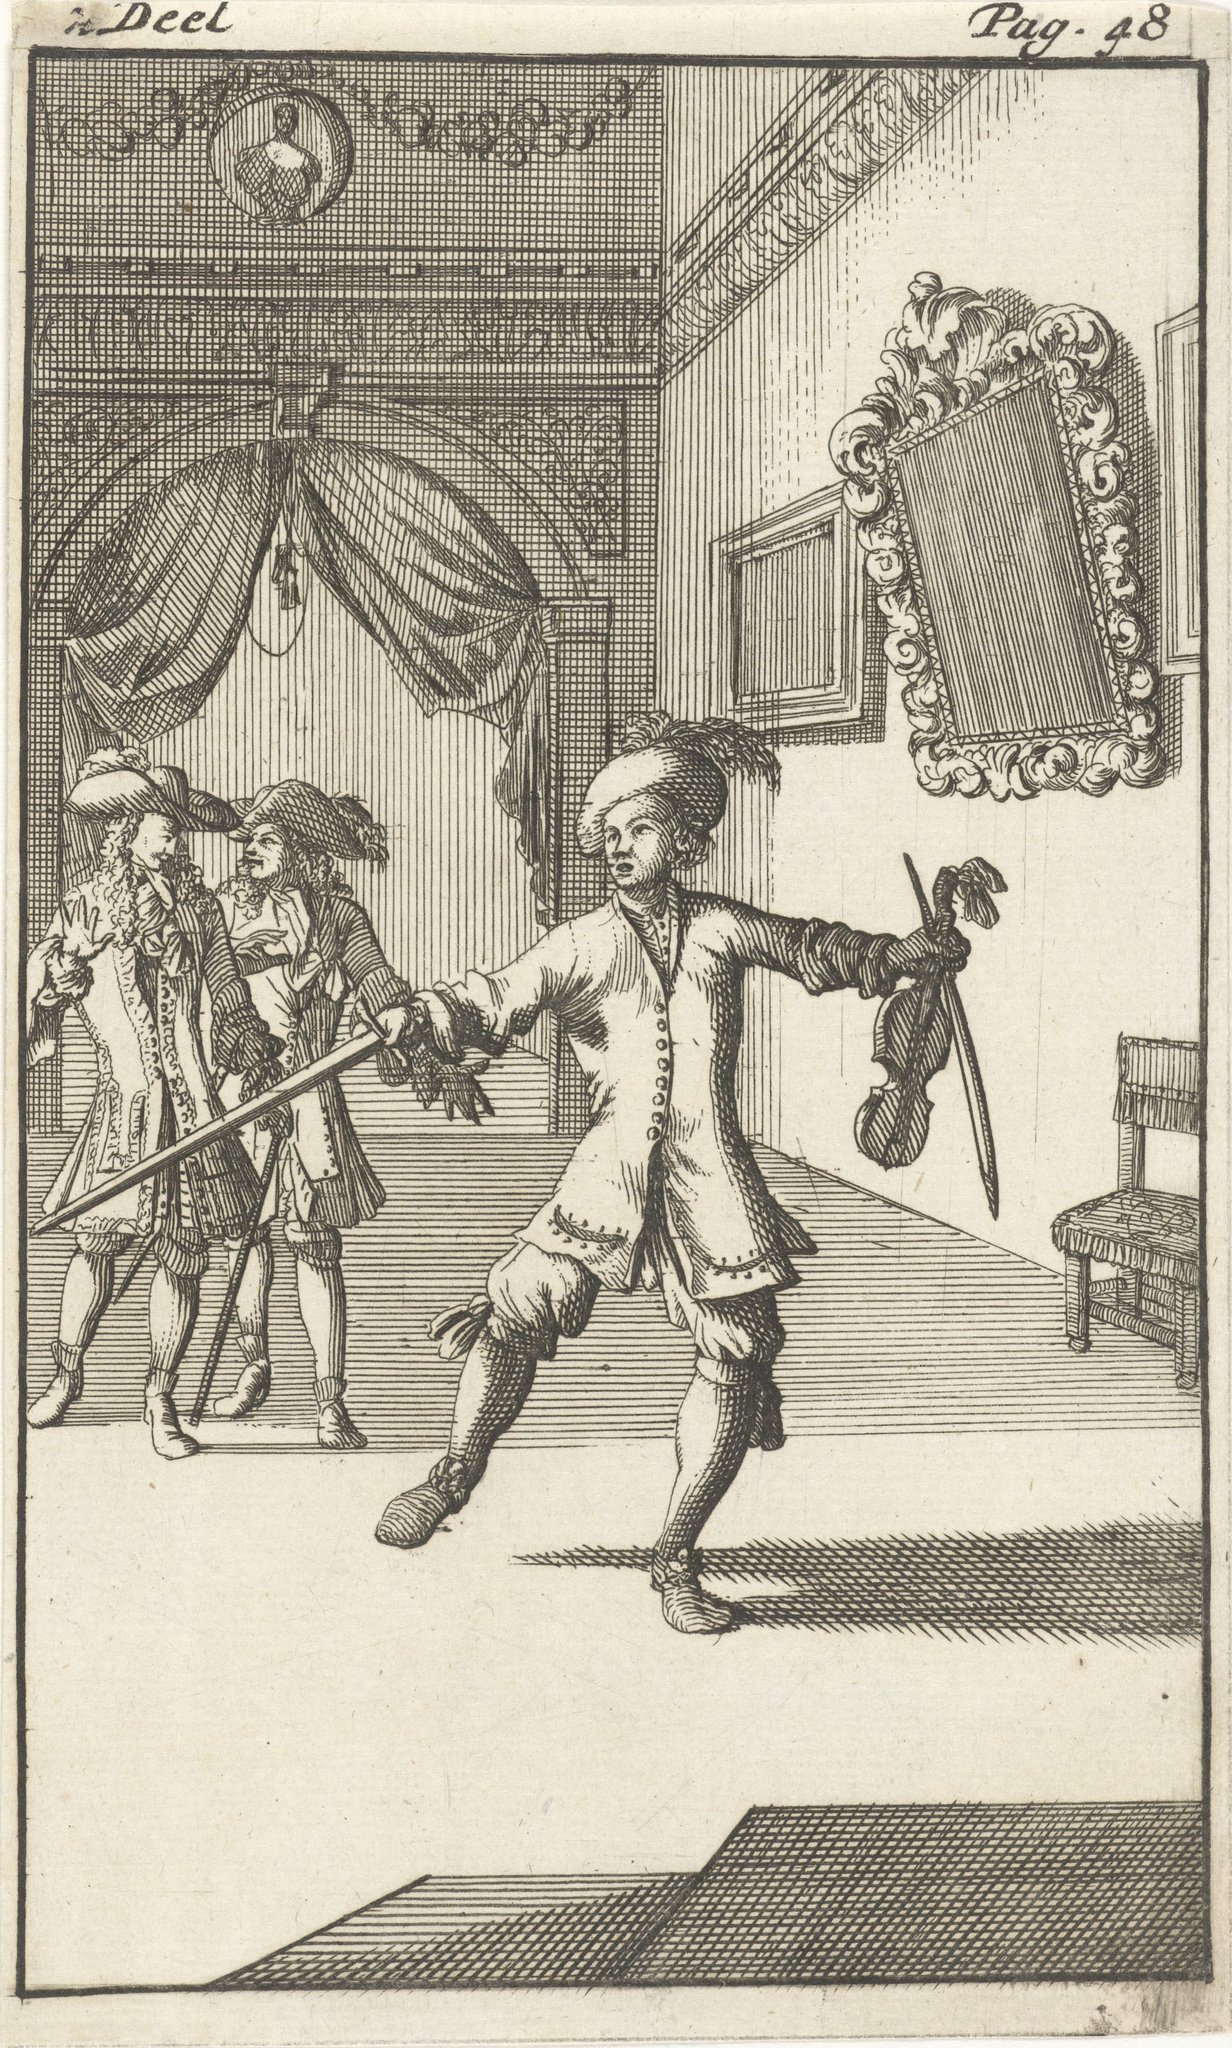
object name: print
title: Mirandor en Belindor ontvangen bezoek van een man, die danspassen uitvoert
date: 1695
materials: paper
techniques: etching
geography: amsterdam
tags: man dancing alone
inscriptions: collector's mark: Lugt 2228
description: Illustratie uit: Heinsius, Nicolaas jr. Den vermakelyken avanturier, ofte De wispelturige, en niet min wonderlyke levens-loop van Mirandor, 2 delen. Amsterdam: Pieter van Amsterdam, 1695, dl. II.